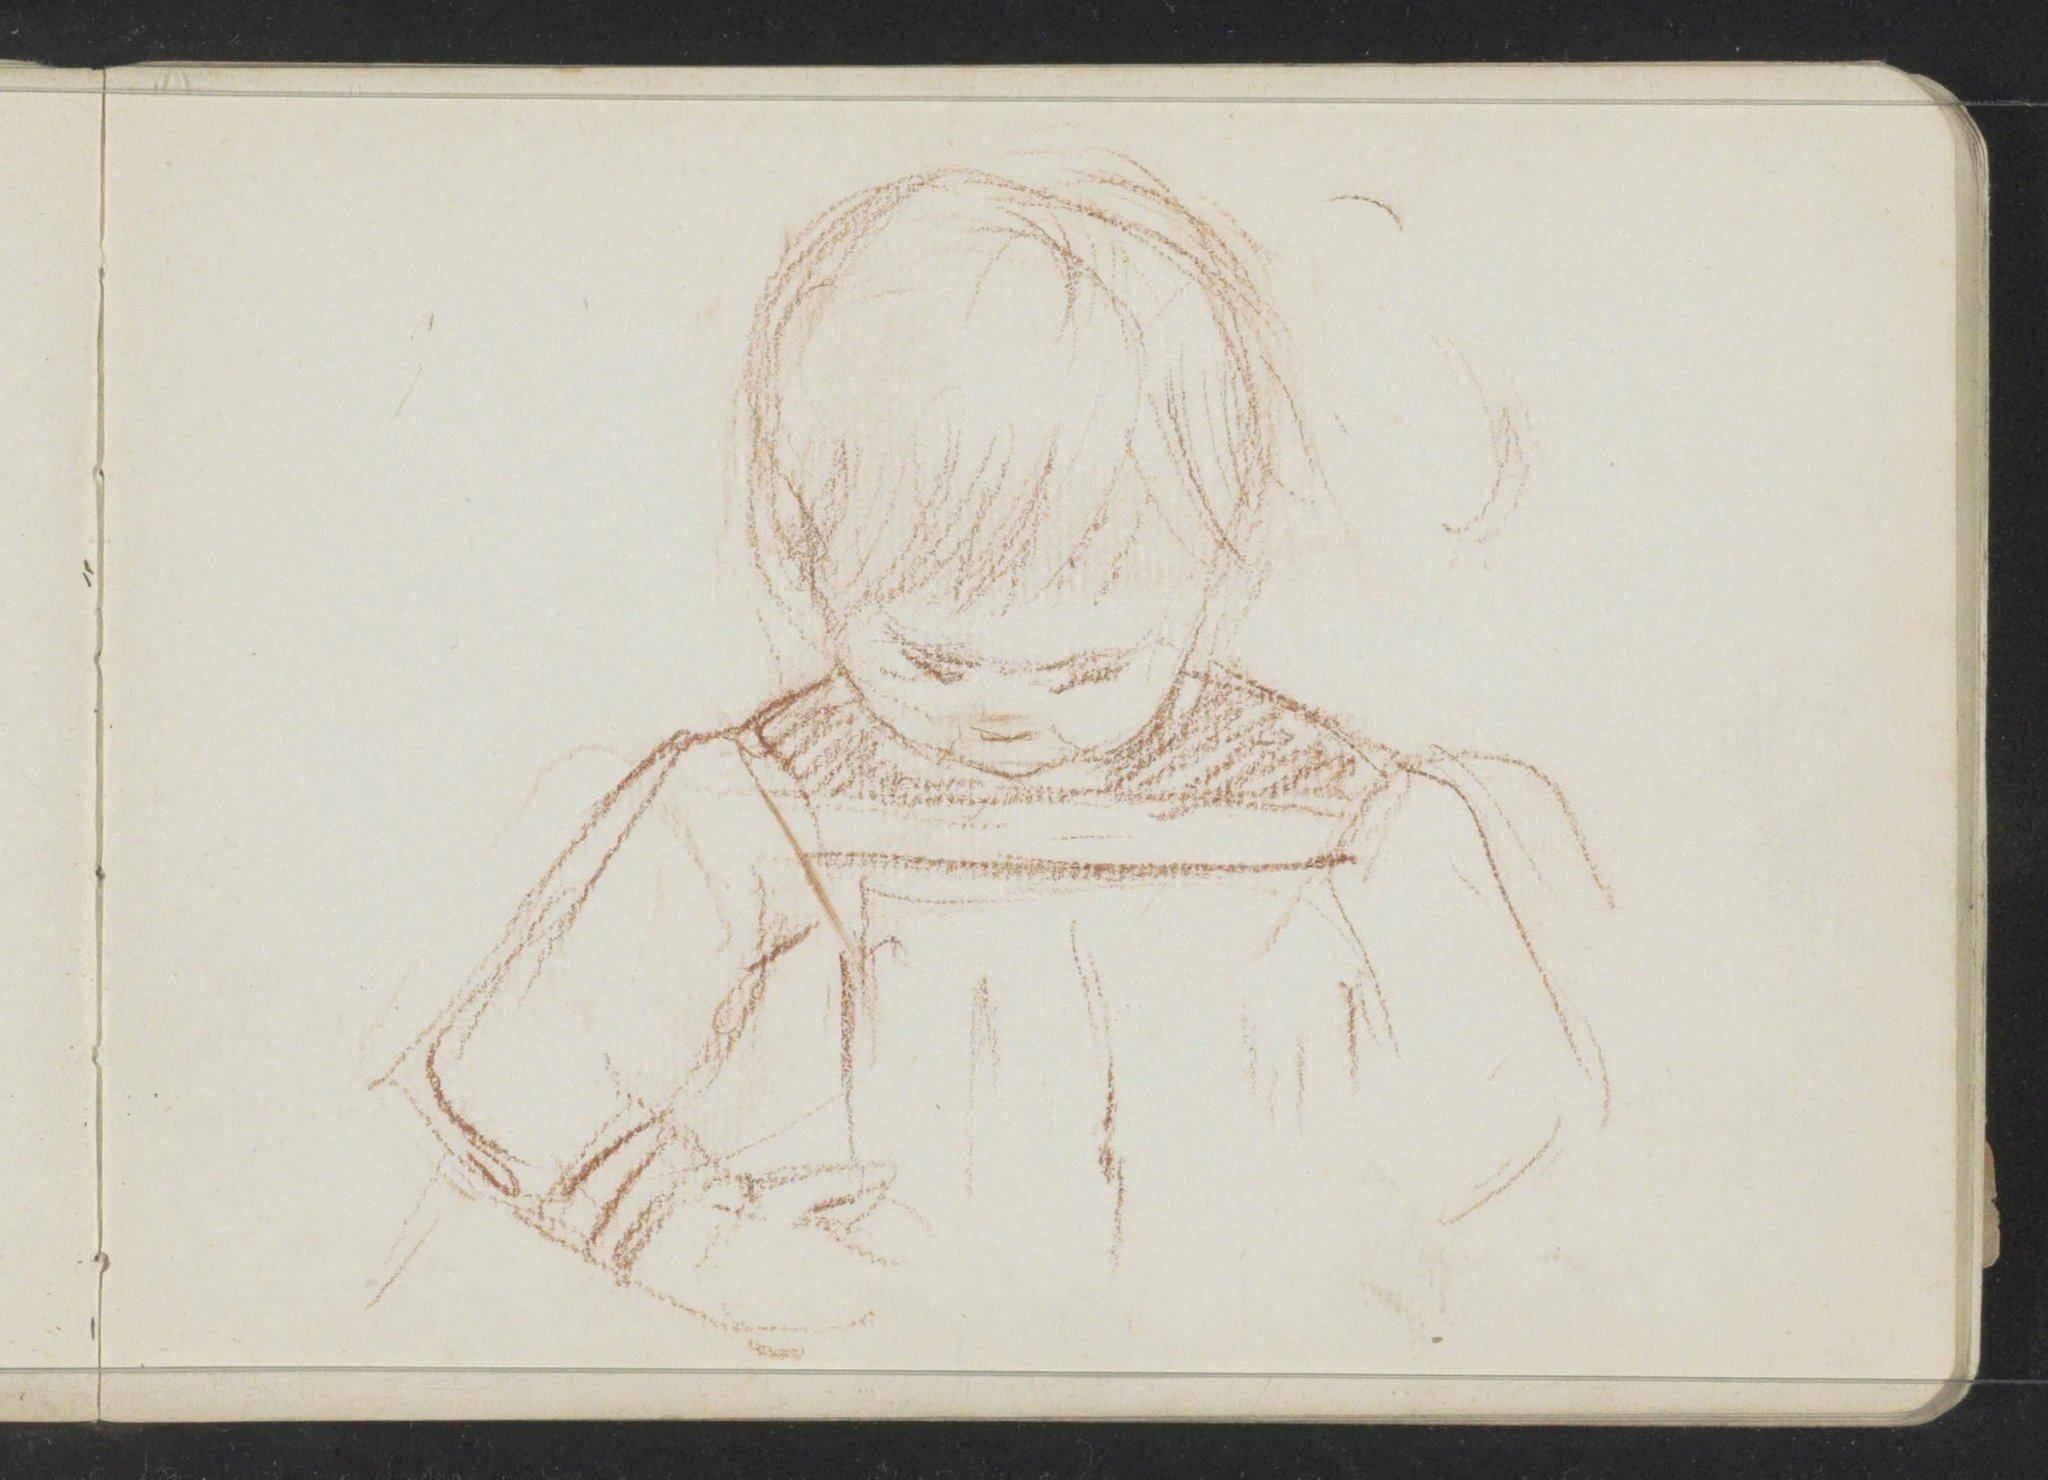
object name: sketchbook leaf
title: Omlaag kijkend kind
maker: johanna van de kamer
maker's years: 1873-1922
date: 1883-1922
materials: chalk, paper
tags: child, looking downwards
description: Blad 9 recto uit een schetsboek met 27 bladen.